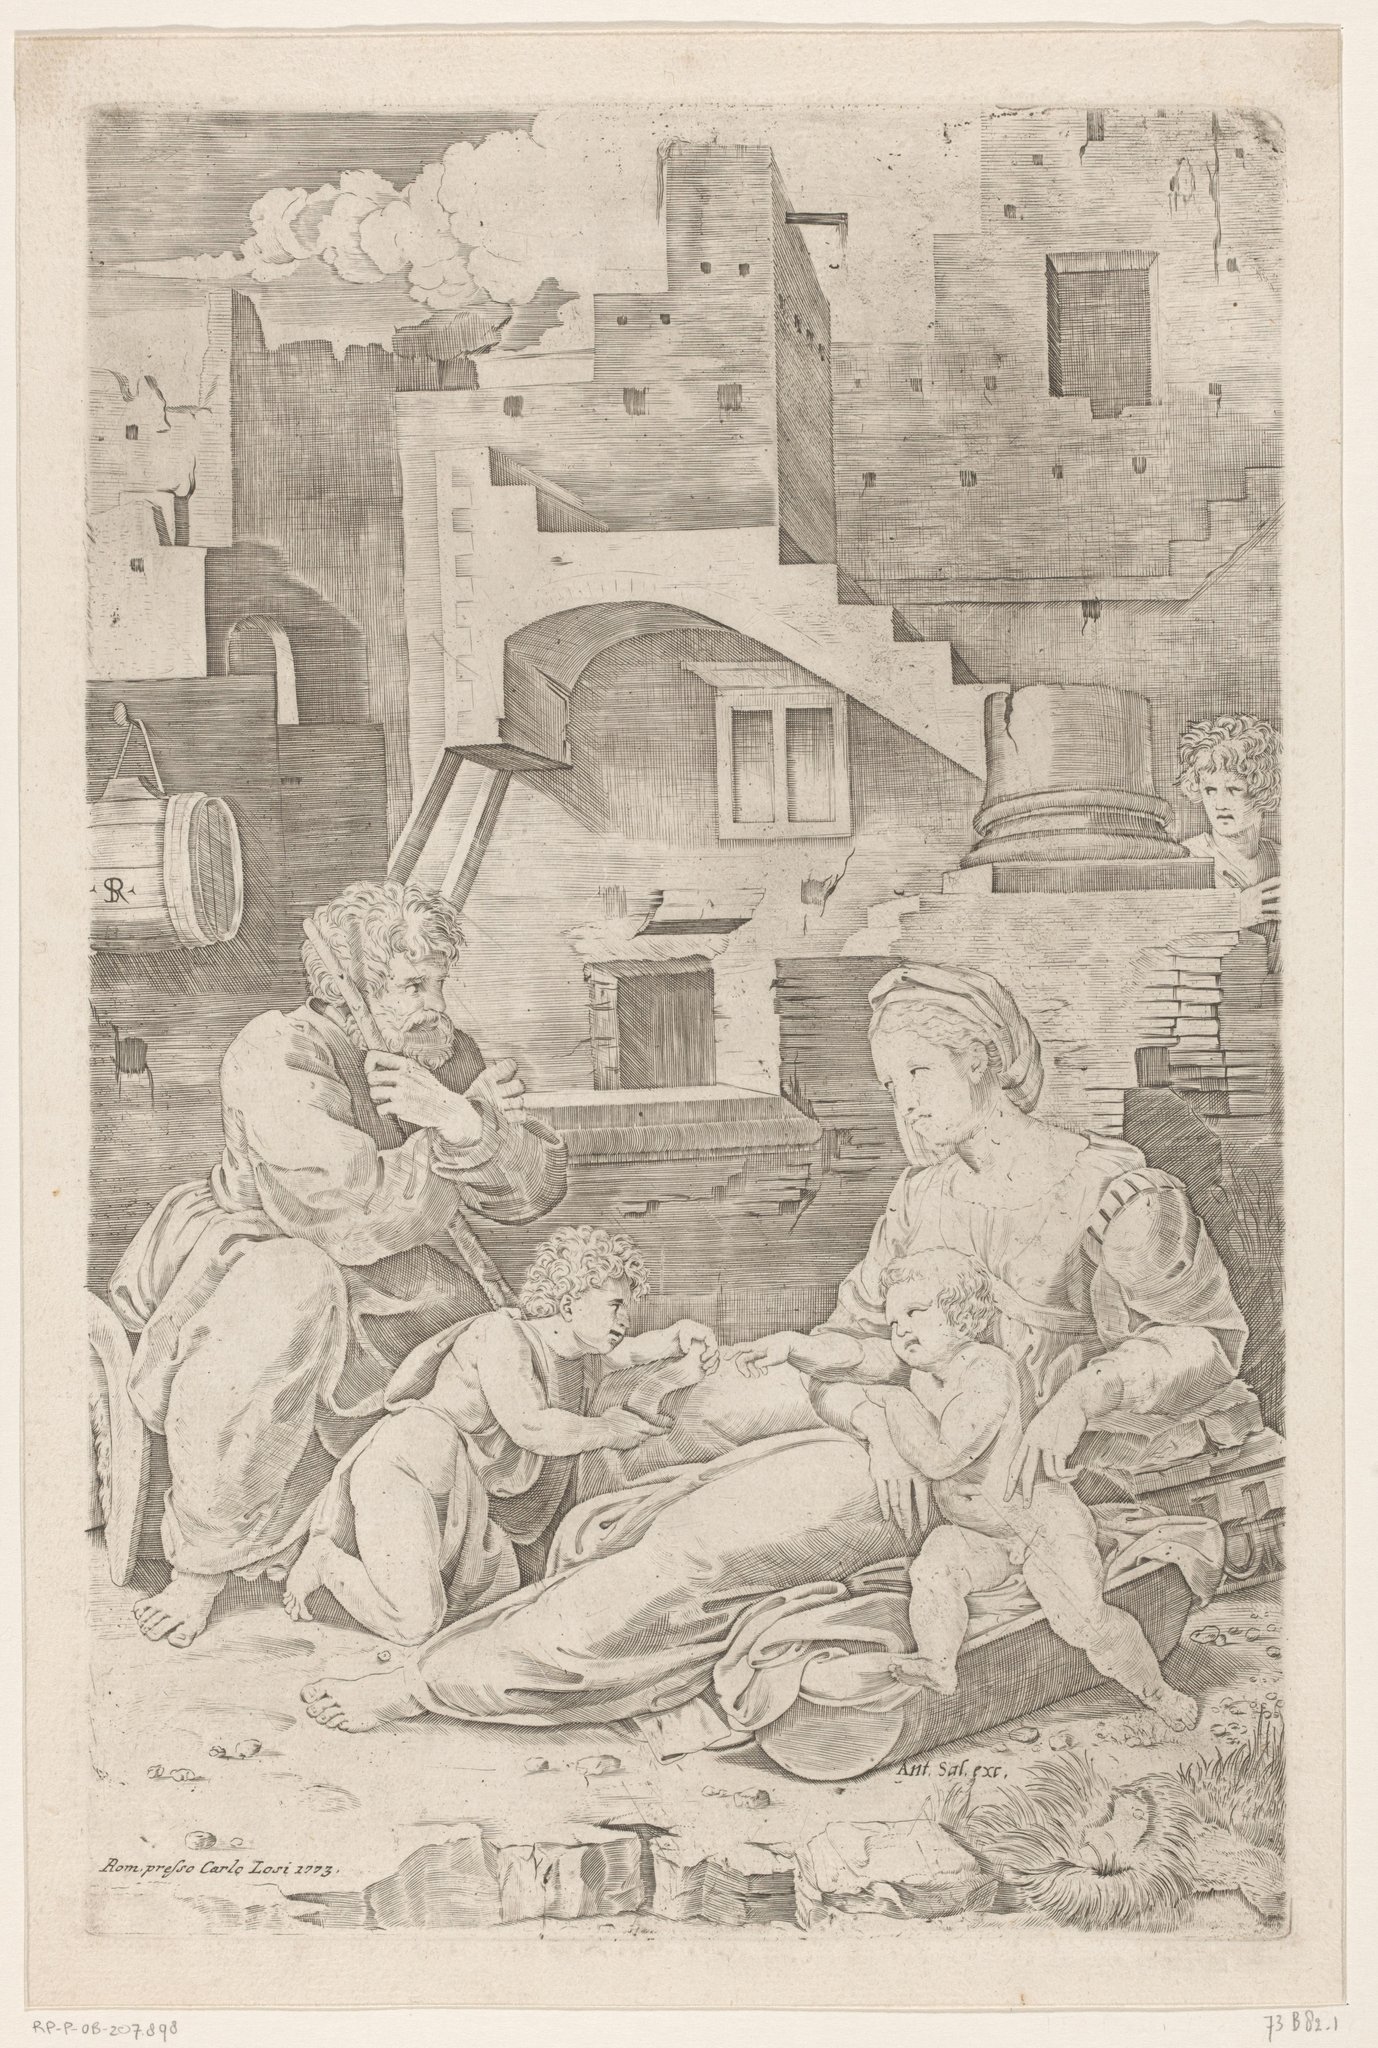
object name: print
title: Heilige Familie met de jonge Johannes de Doper voor een vervallen gebouw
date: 1498-1532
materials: paper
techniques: engraving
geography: italy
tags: ruin of a building ~ architecture, holy family with john the baptist (as child)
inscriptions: collector's mark: Lugt 2028, collector's mark: Lugt 2228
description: De Heilige Familie zit met de jonge Johannes de Doper voor een vervallen gebouw. Het Christuskind zit op zijn kribbe en leunt tegen de dij van Maria. Johannes leunt tegen de knie van Maria en houdt een briefje in zijn handen. Jozef zit links. Op de achtergrond rechts staat een man die naar de Heilige Familie gluurt.